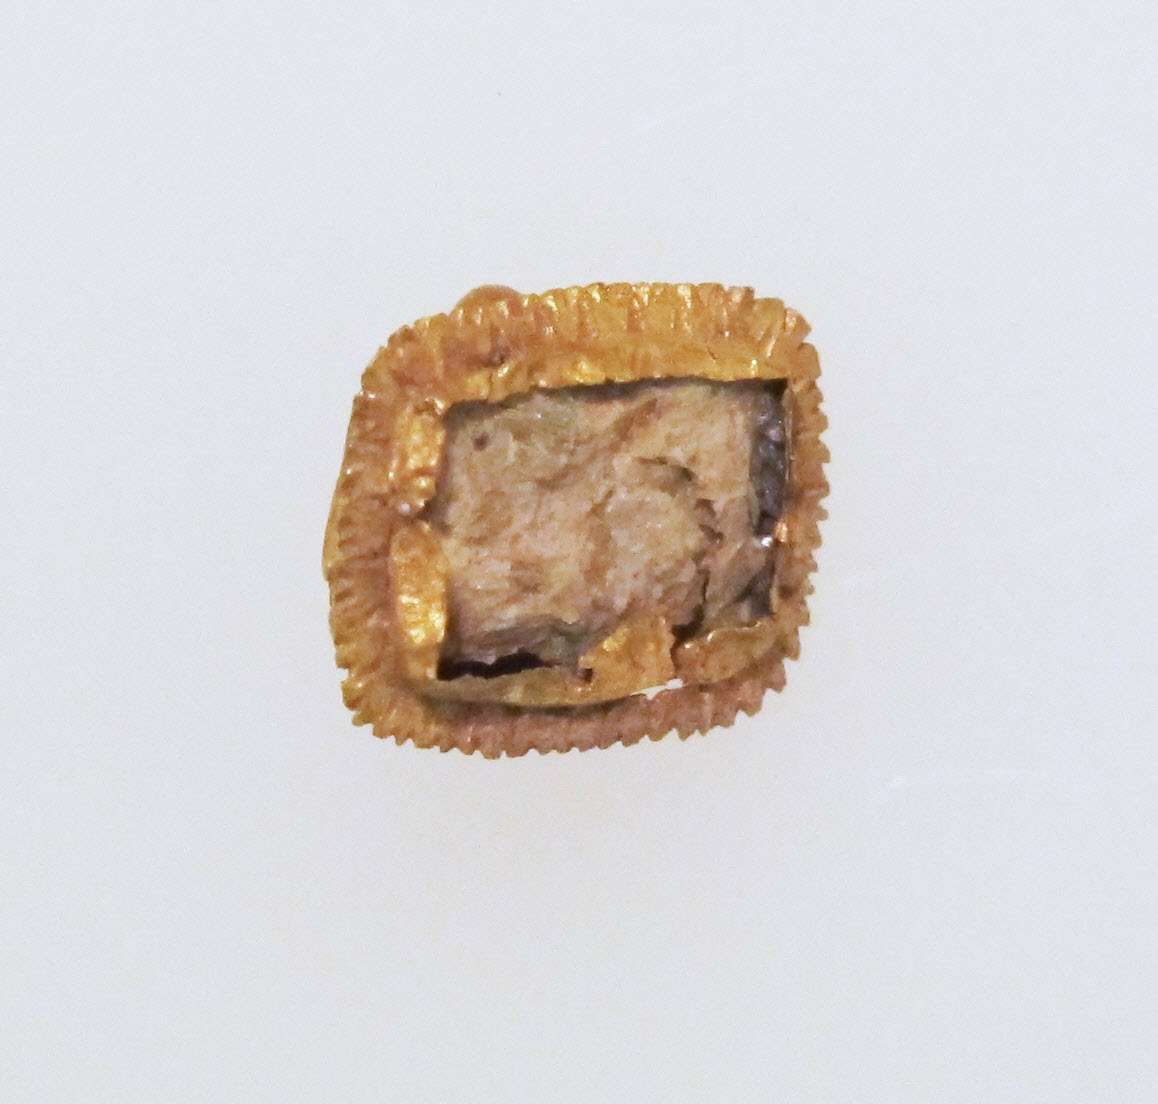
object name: earring hook type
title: Earring-hook type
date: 7000 BCE-330 CE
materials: gold